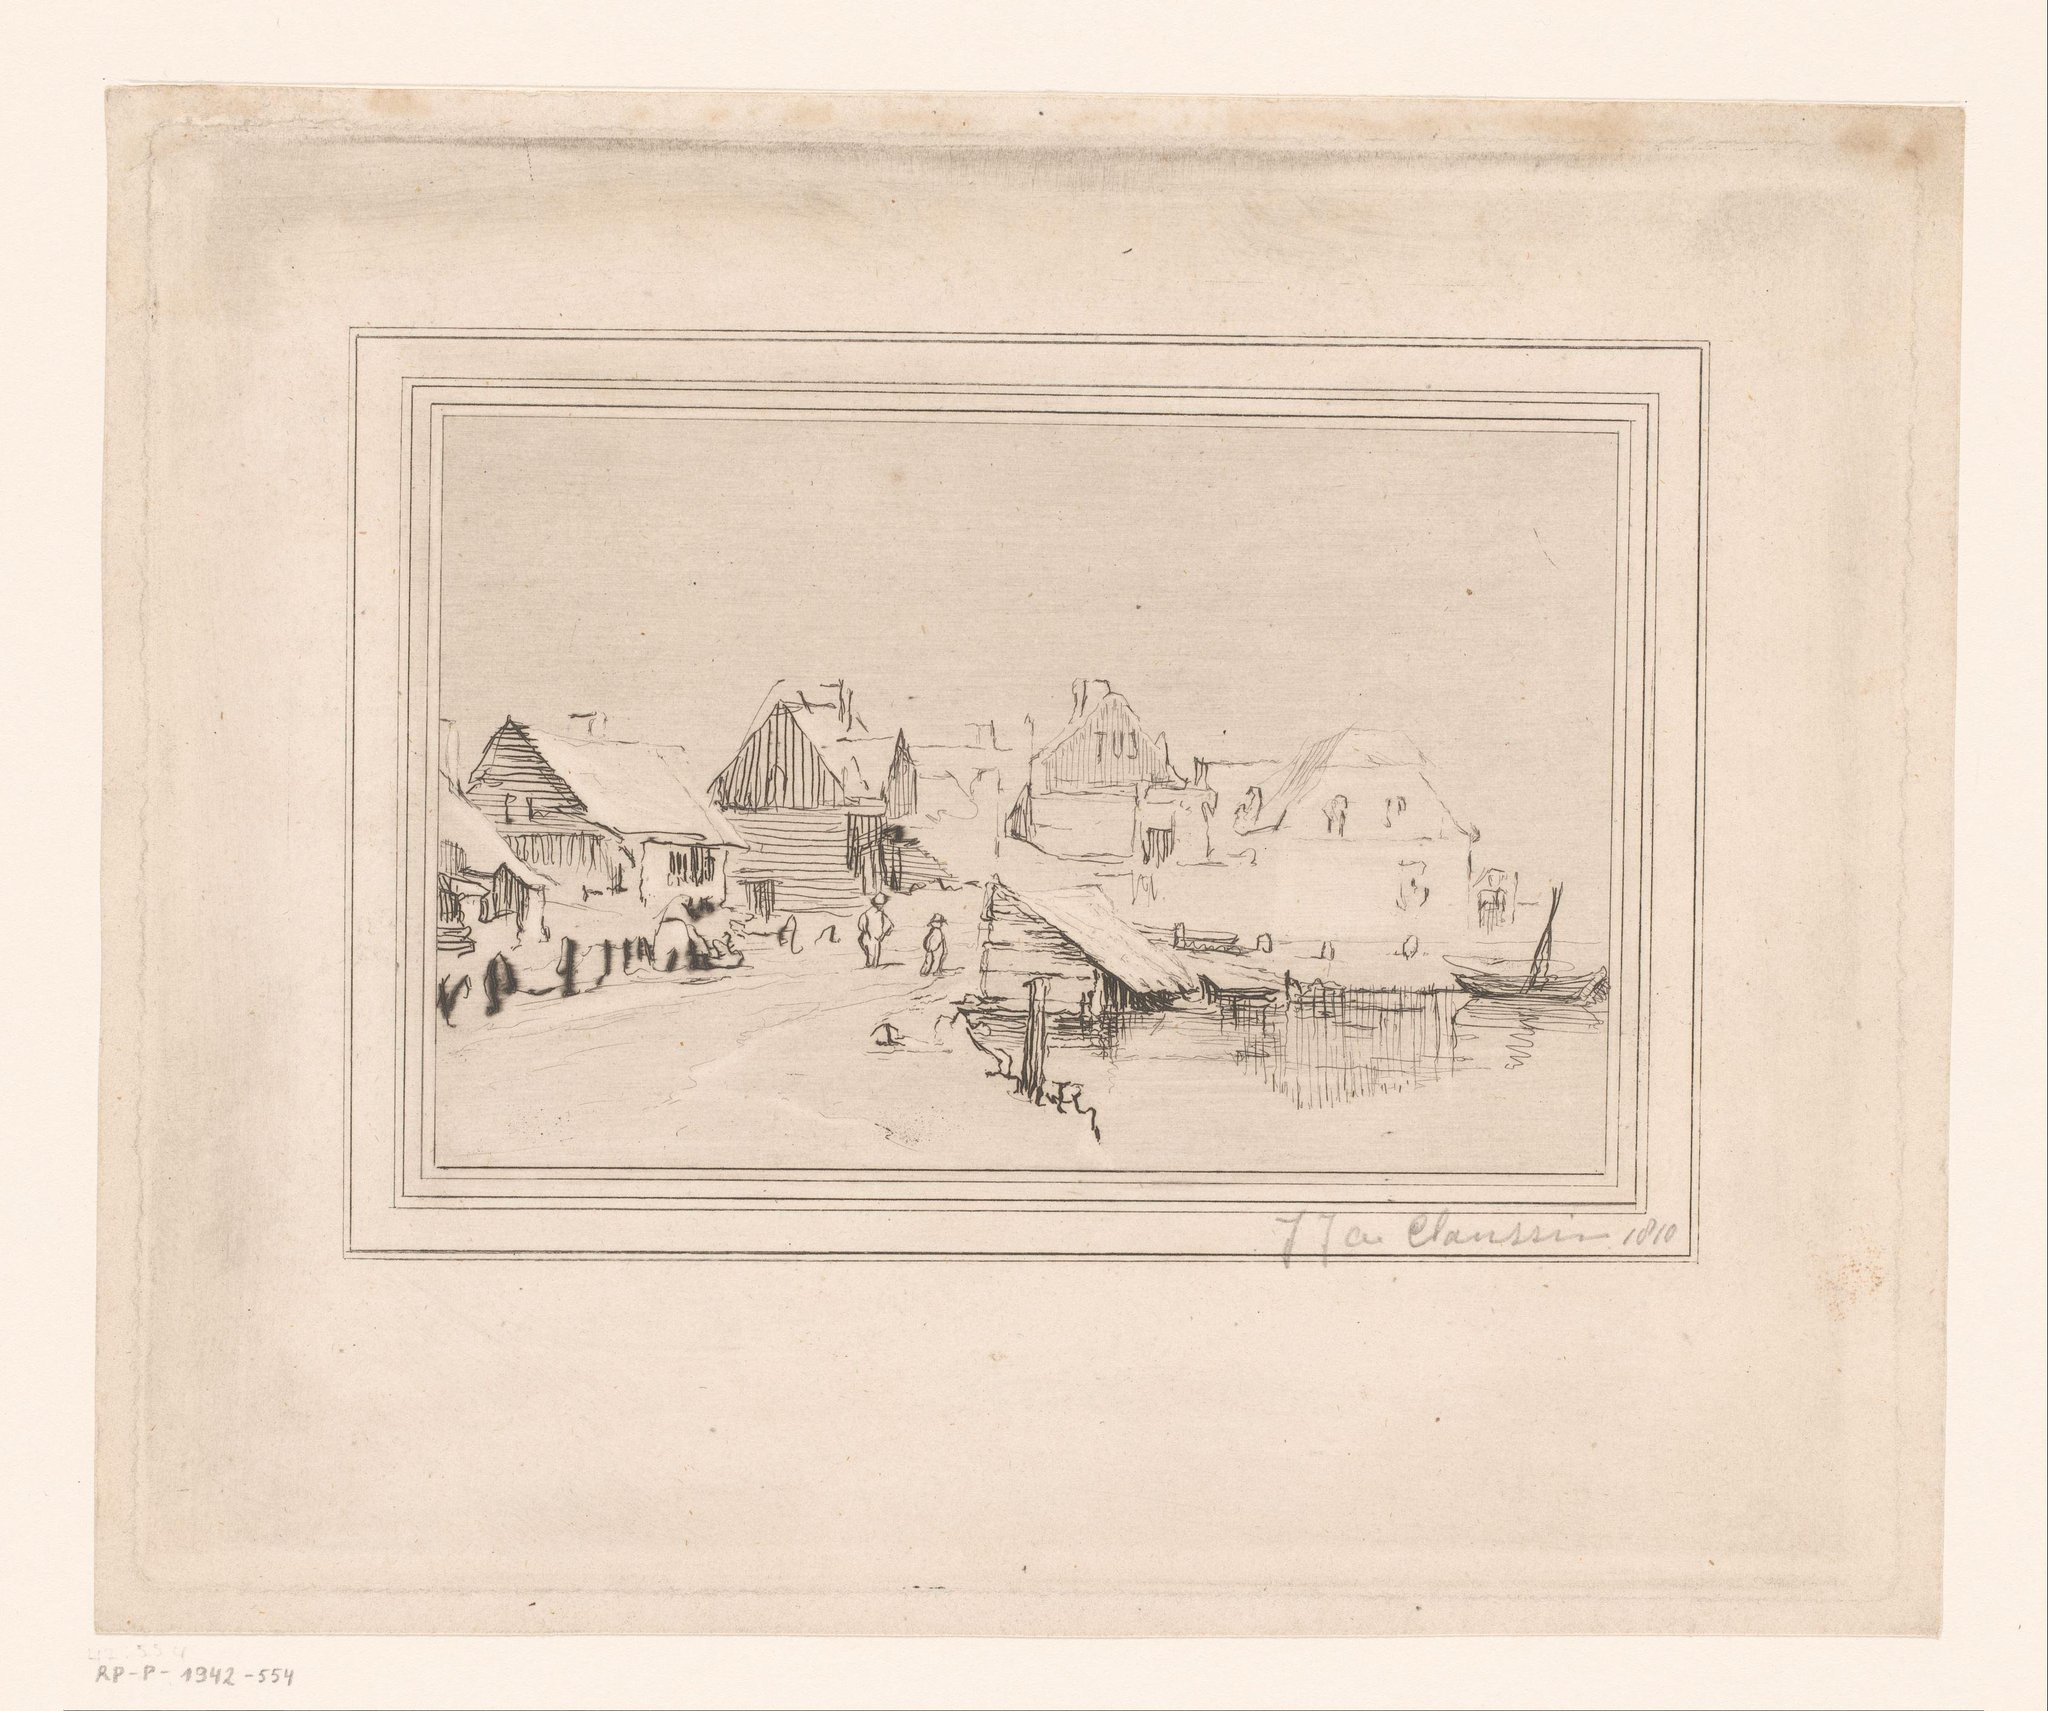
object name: print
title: Zicht op een stad aan het water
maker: ignace-joseph de claussin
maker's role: print maker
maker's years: 1766-1844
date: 1810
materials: paper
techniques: drypoint, etching, intaglio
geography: france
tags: lake, outskirts of city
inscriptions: collector's mark: Lugt 2228, watermark